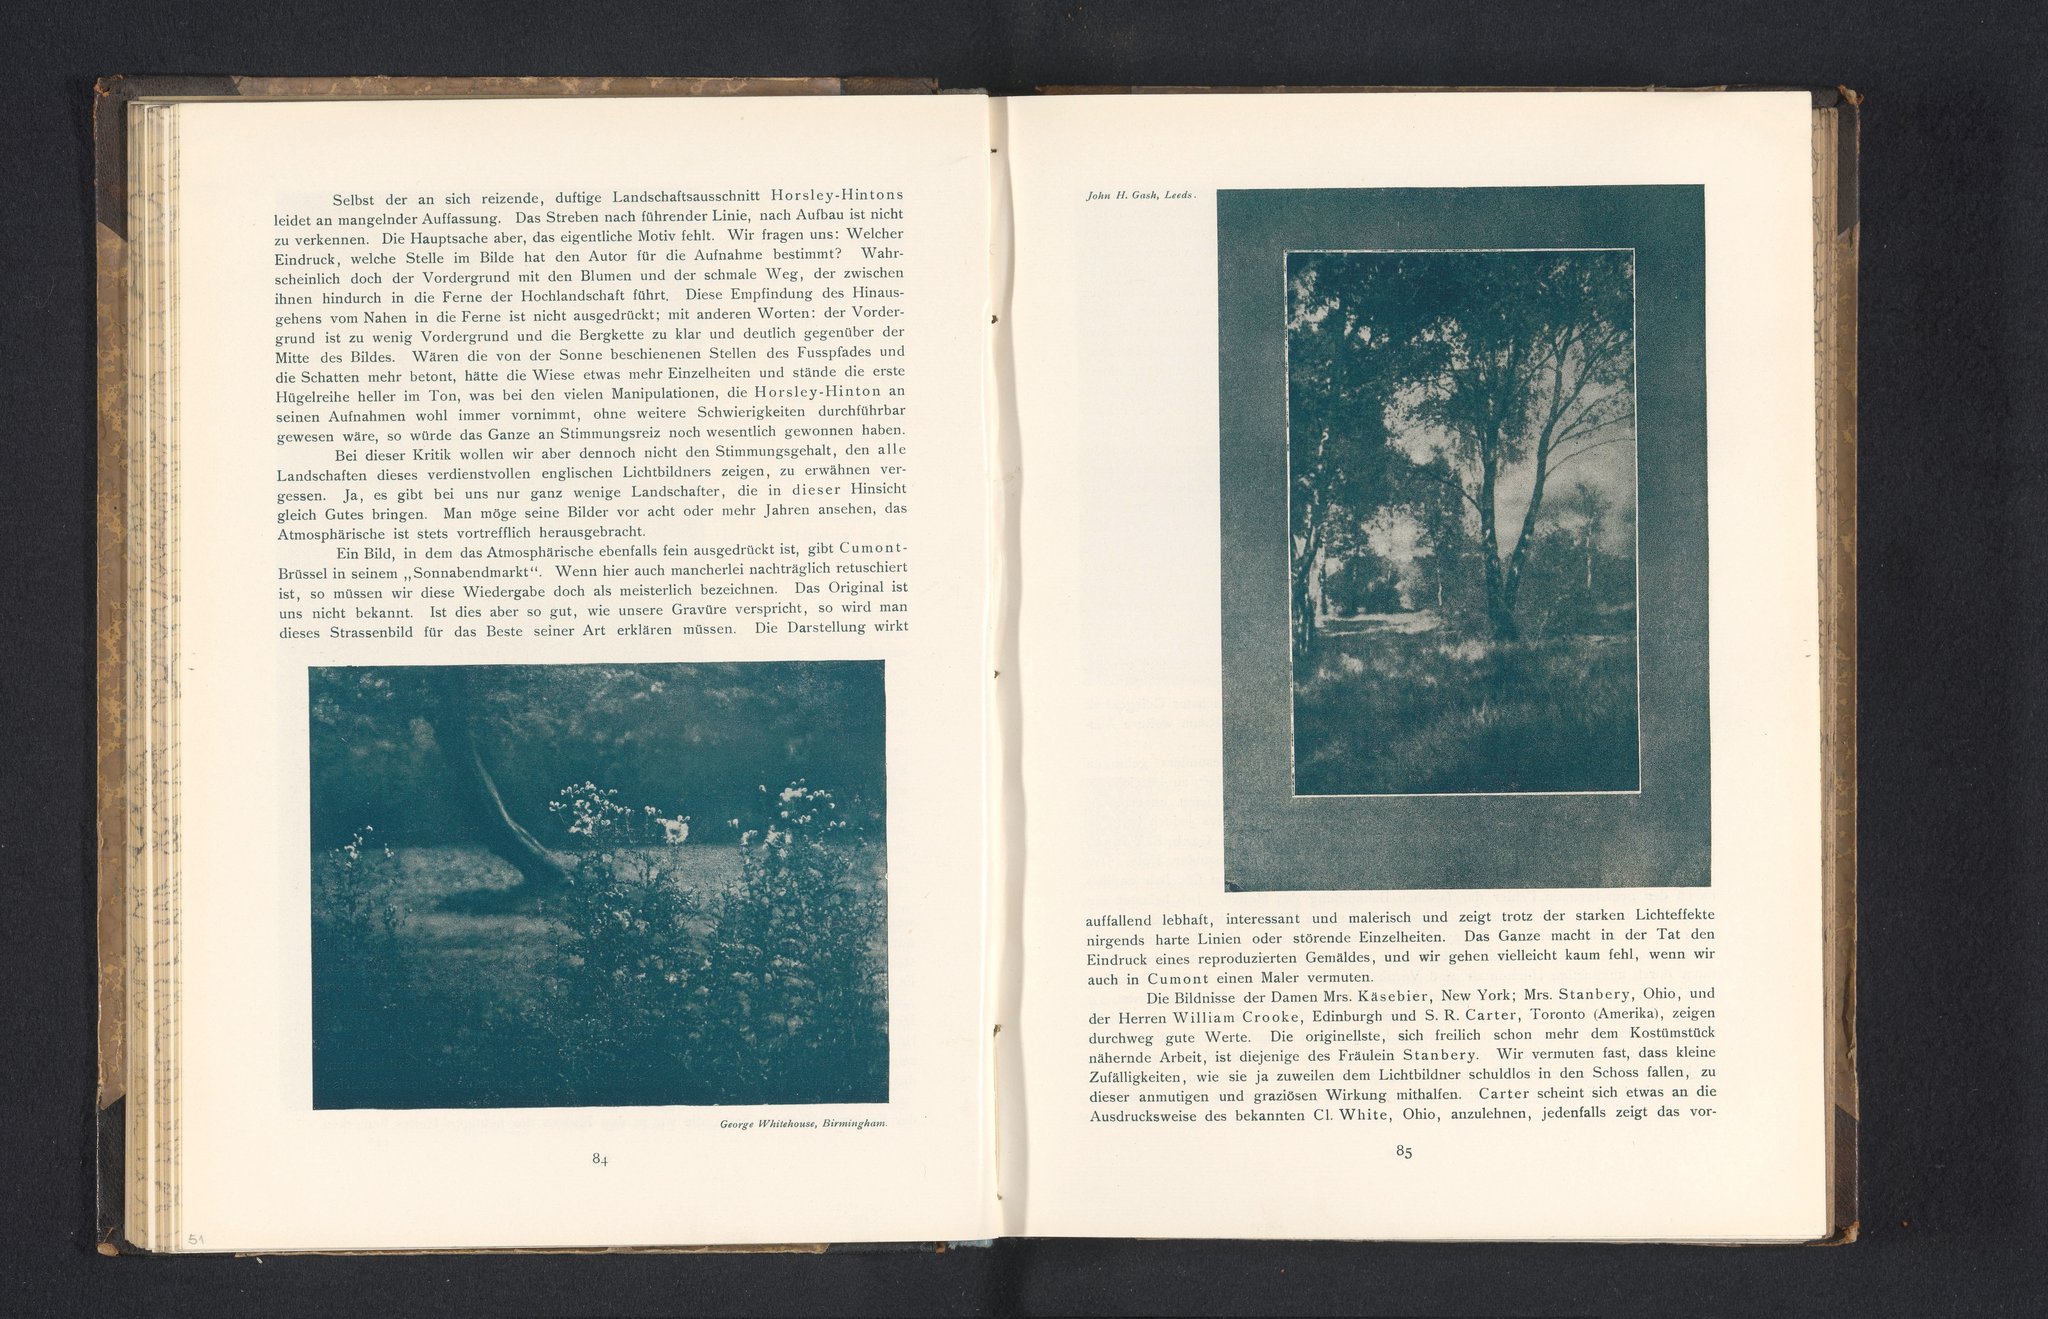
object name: page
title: Bloeiende struik, met op de achtergrond een boom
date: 1898-1903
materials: paper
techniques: autotype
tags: flowers, trees